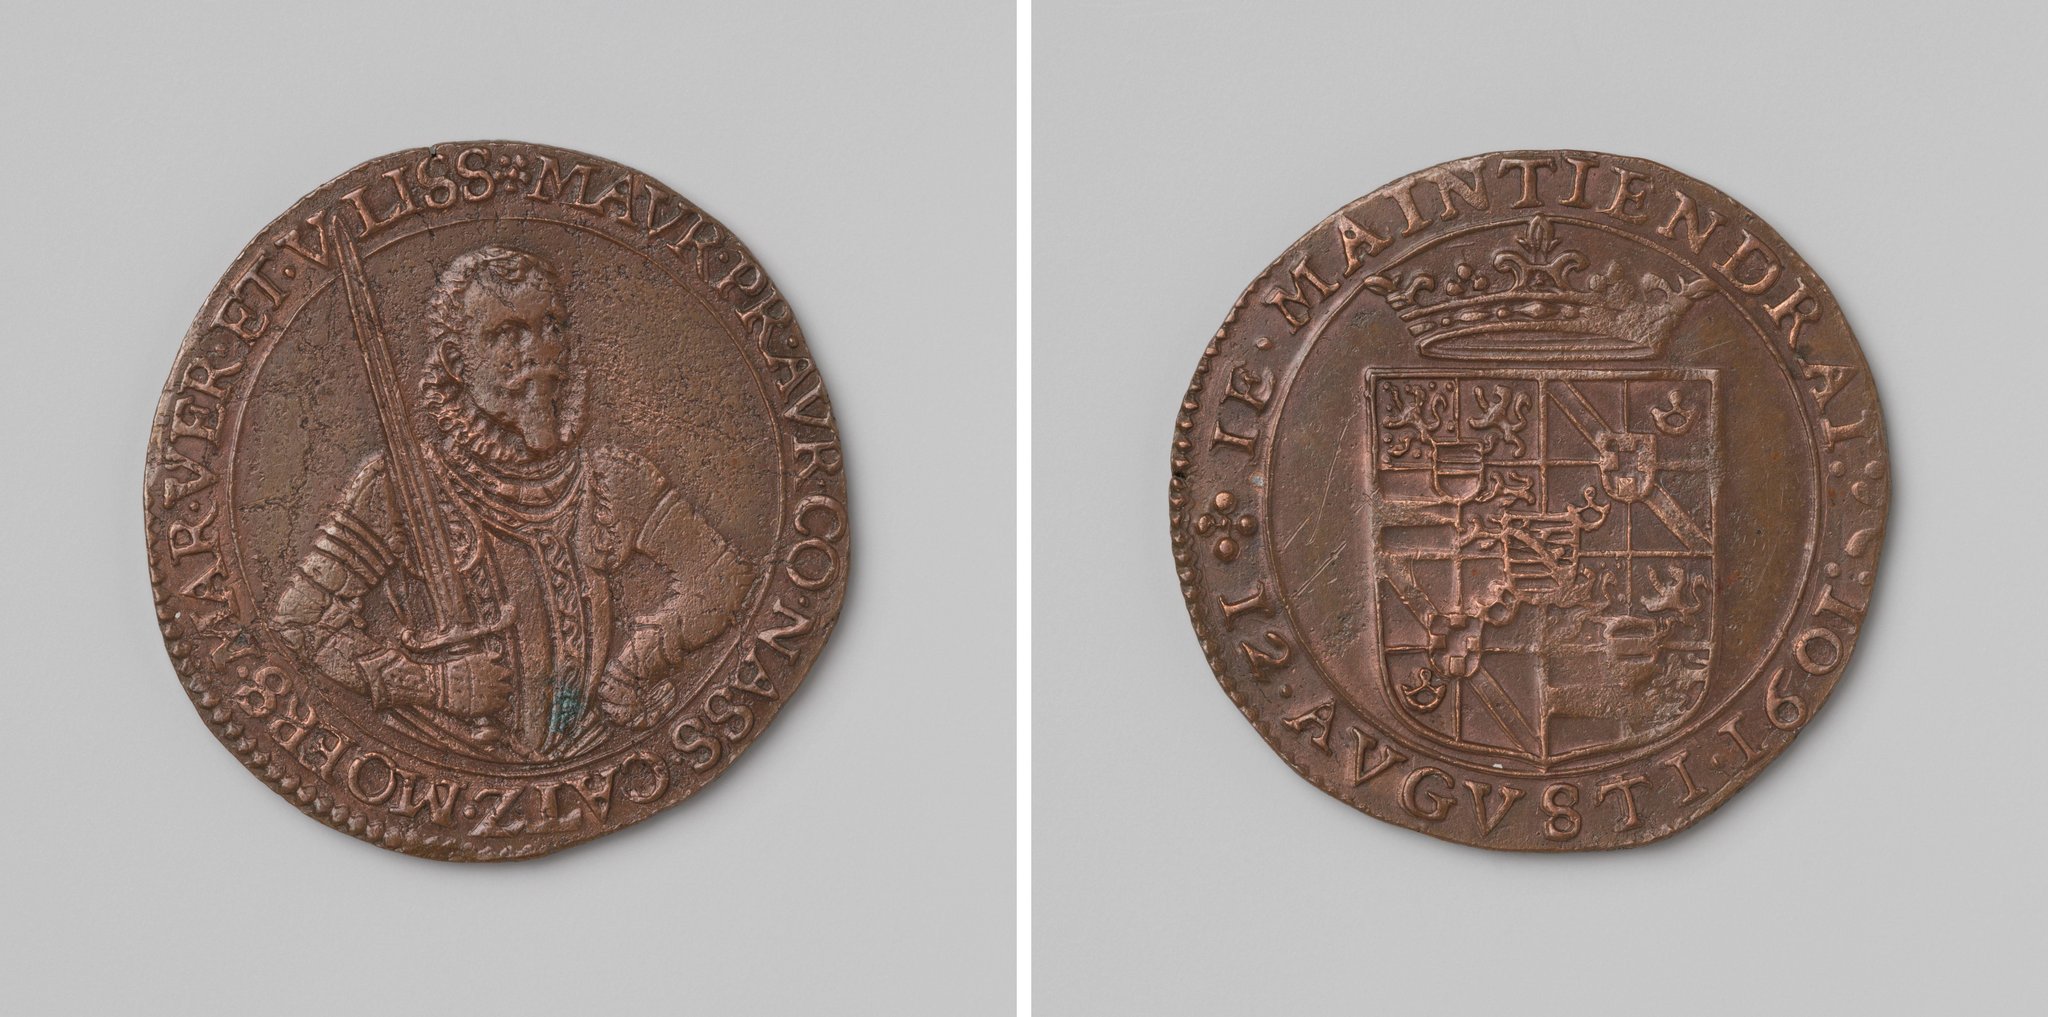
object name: jeton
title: Maurits, graaf van Nassau, ingehuldigd als graaf van Moers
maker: Anonymous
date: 1601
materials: copper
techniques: striking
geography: dordrecht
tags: the hague, maurice (prince of orange)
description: Koperen penning. Voorzijde: portret man met zwaard in rechterhand, rustend op schouder binnen omschrift. Keerzijde: gekroond wapenschild binnen omschrift.